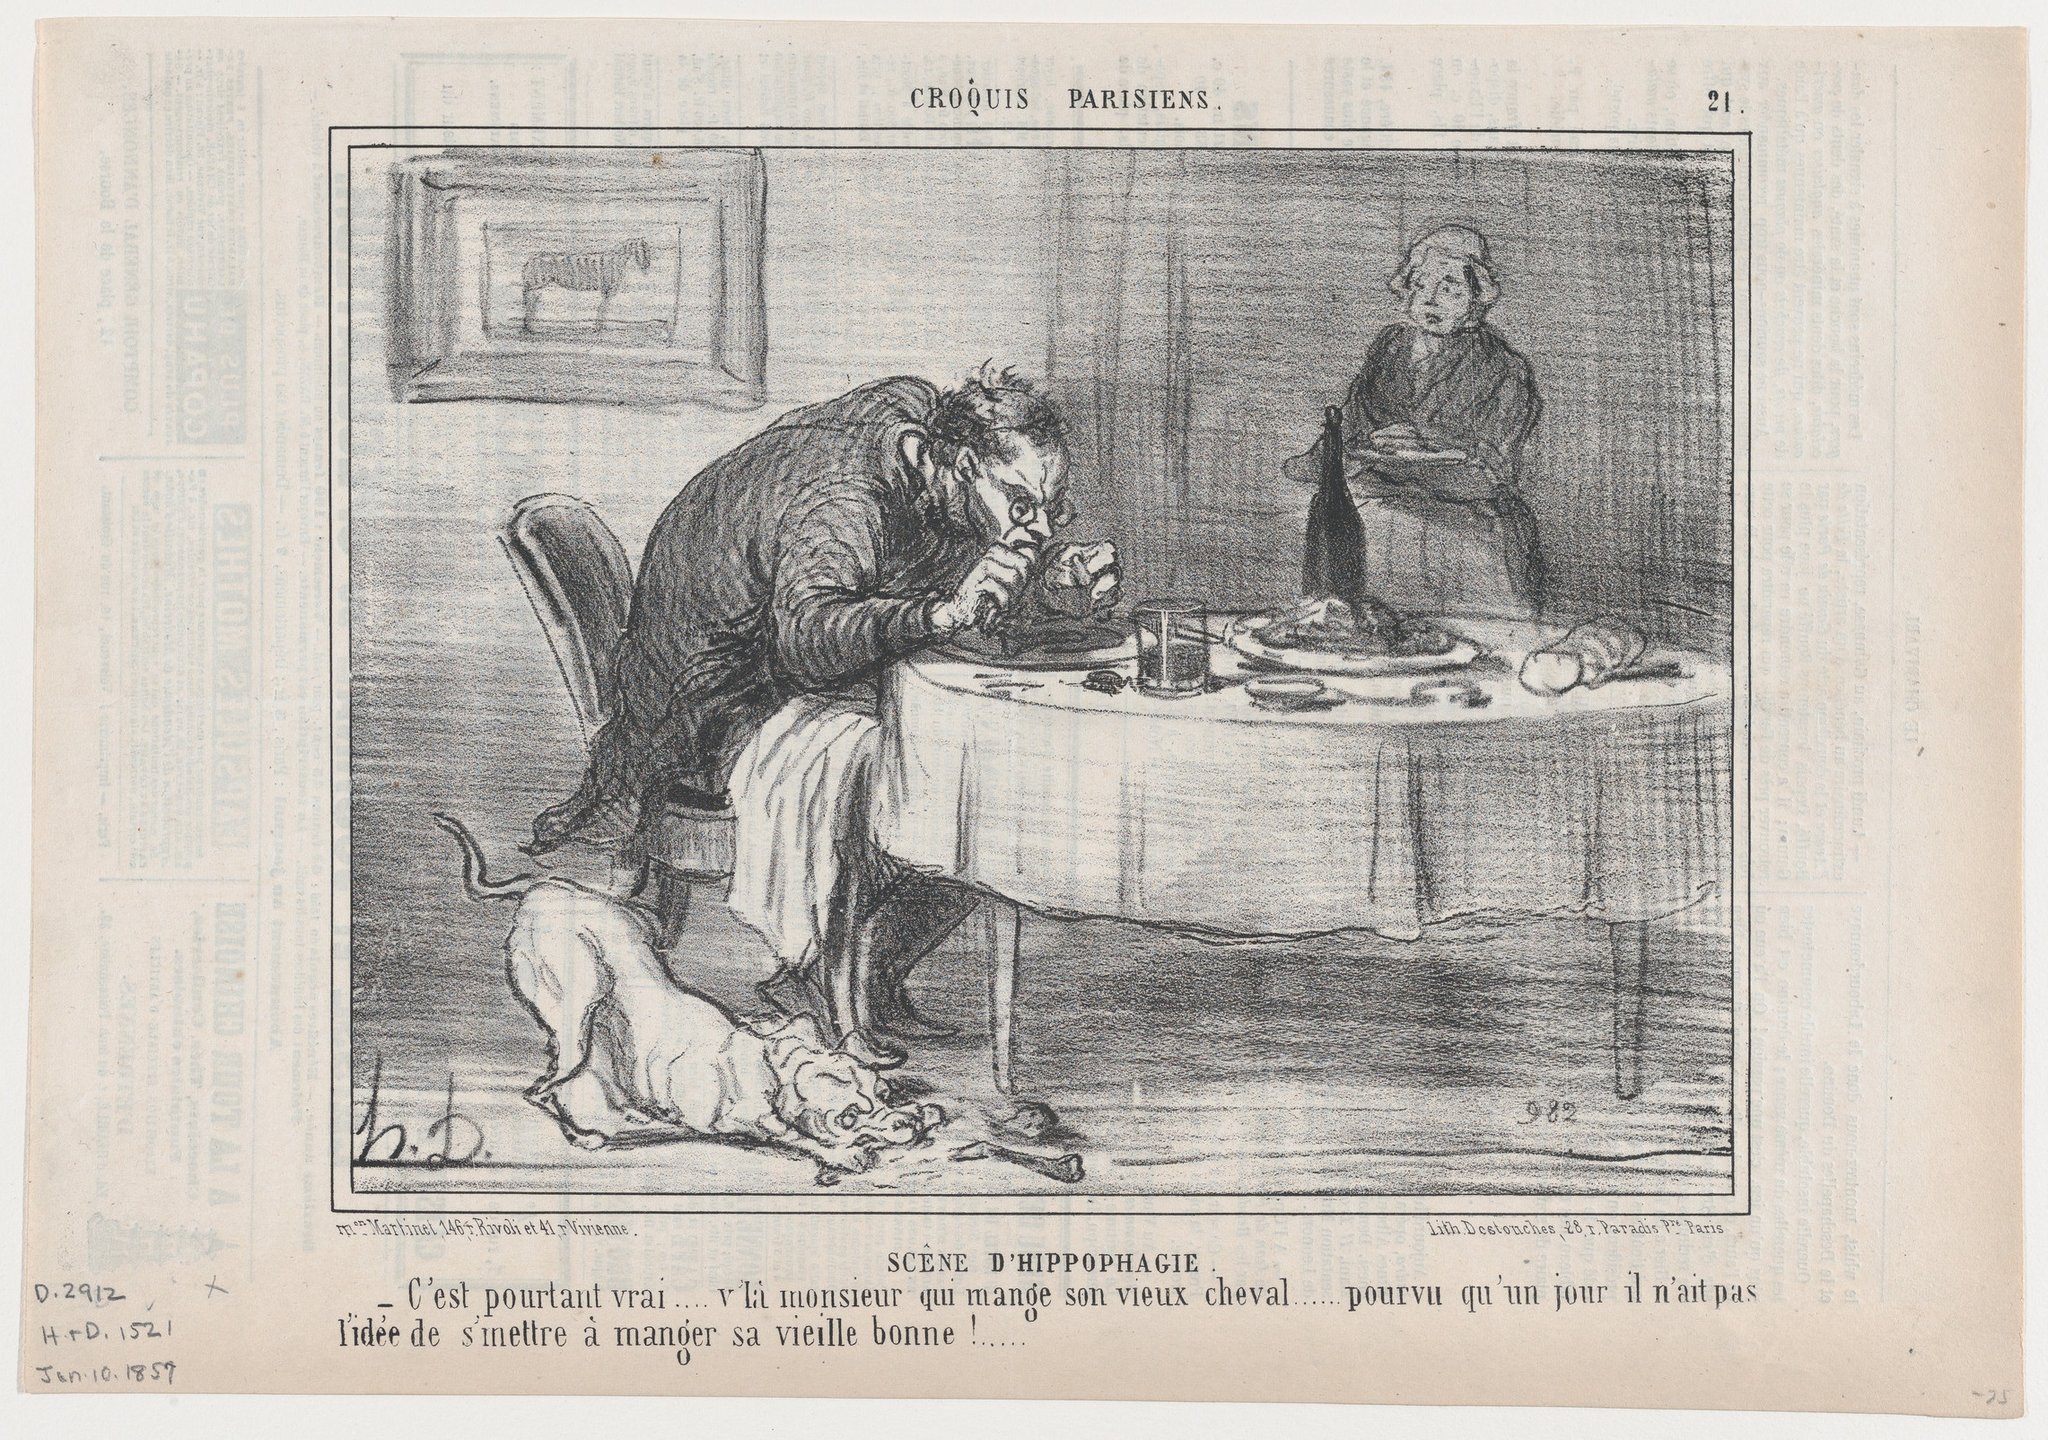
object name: print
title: Scêne d'Hippophagie, from Croquis Dramatiques, published in Le Charivari, January 10, 1857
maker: honoré daumier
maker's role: artist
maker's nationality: french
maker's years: 1808-1879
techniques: lithograph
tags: men,women,dogs,dining,tables